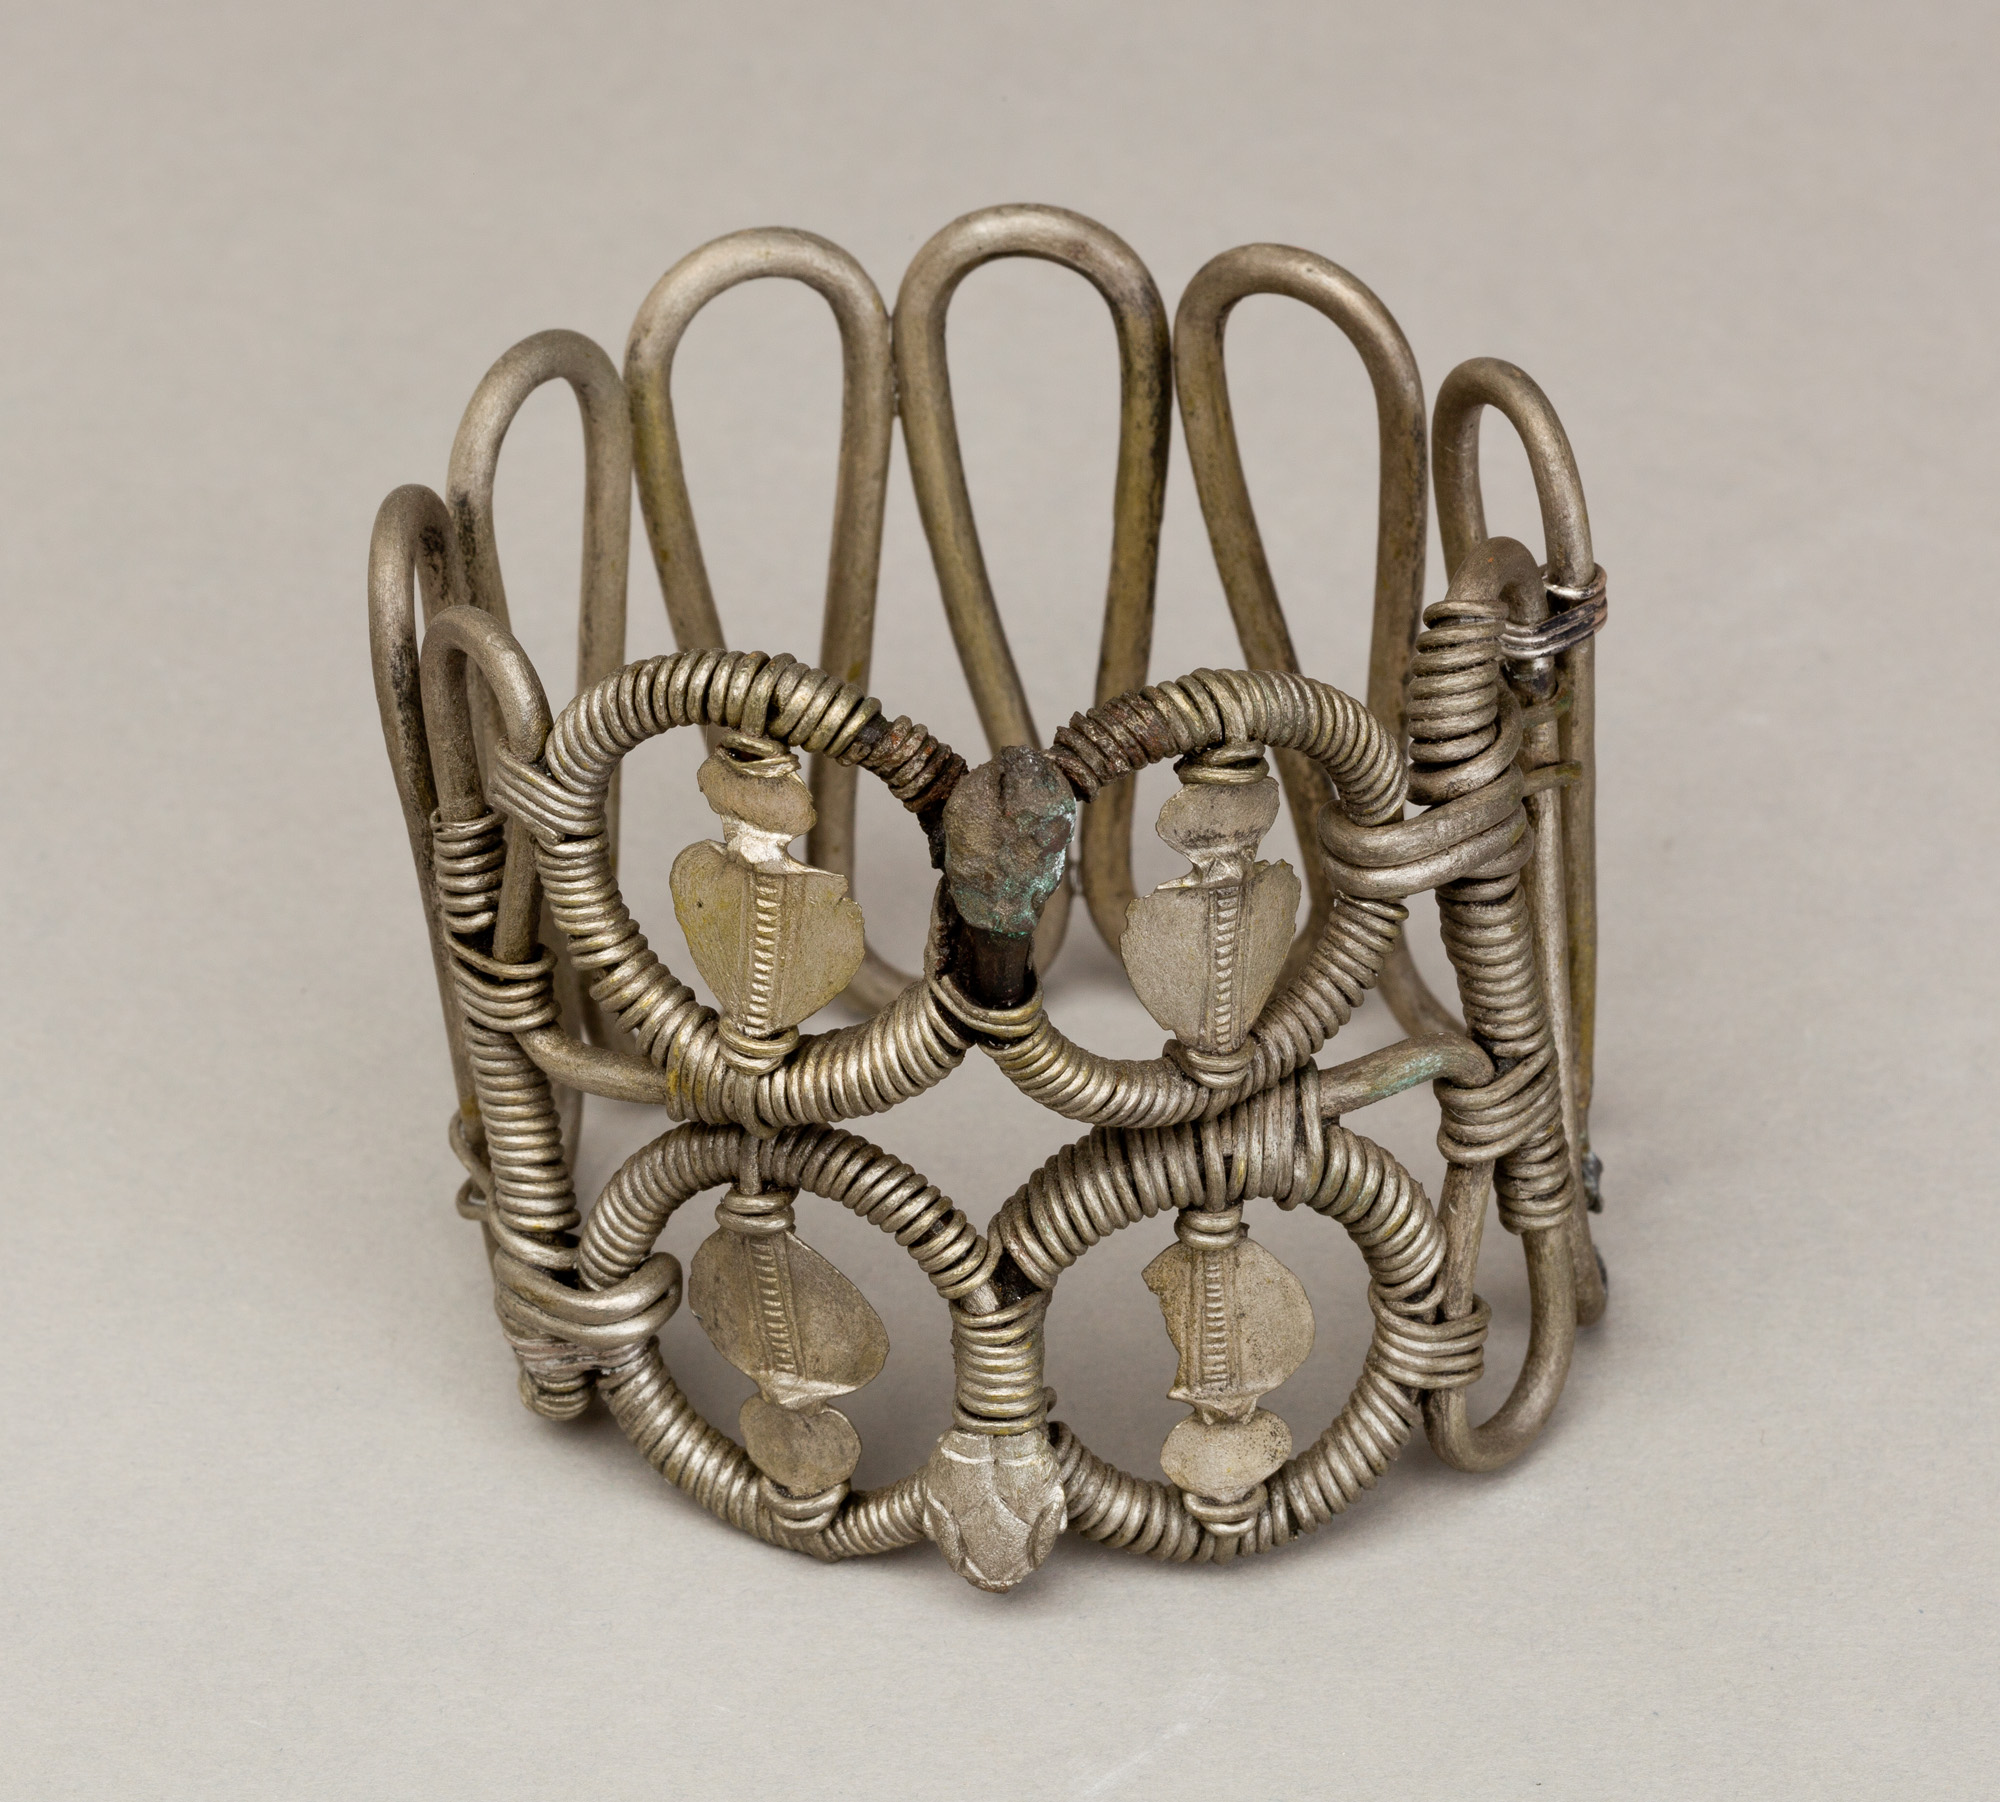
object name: bracelet or armlet, uraei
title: Bracelet or armlet with uraei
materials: silver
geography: egypt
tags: serpents